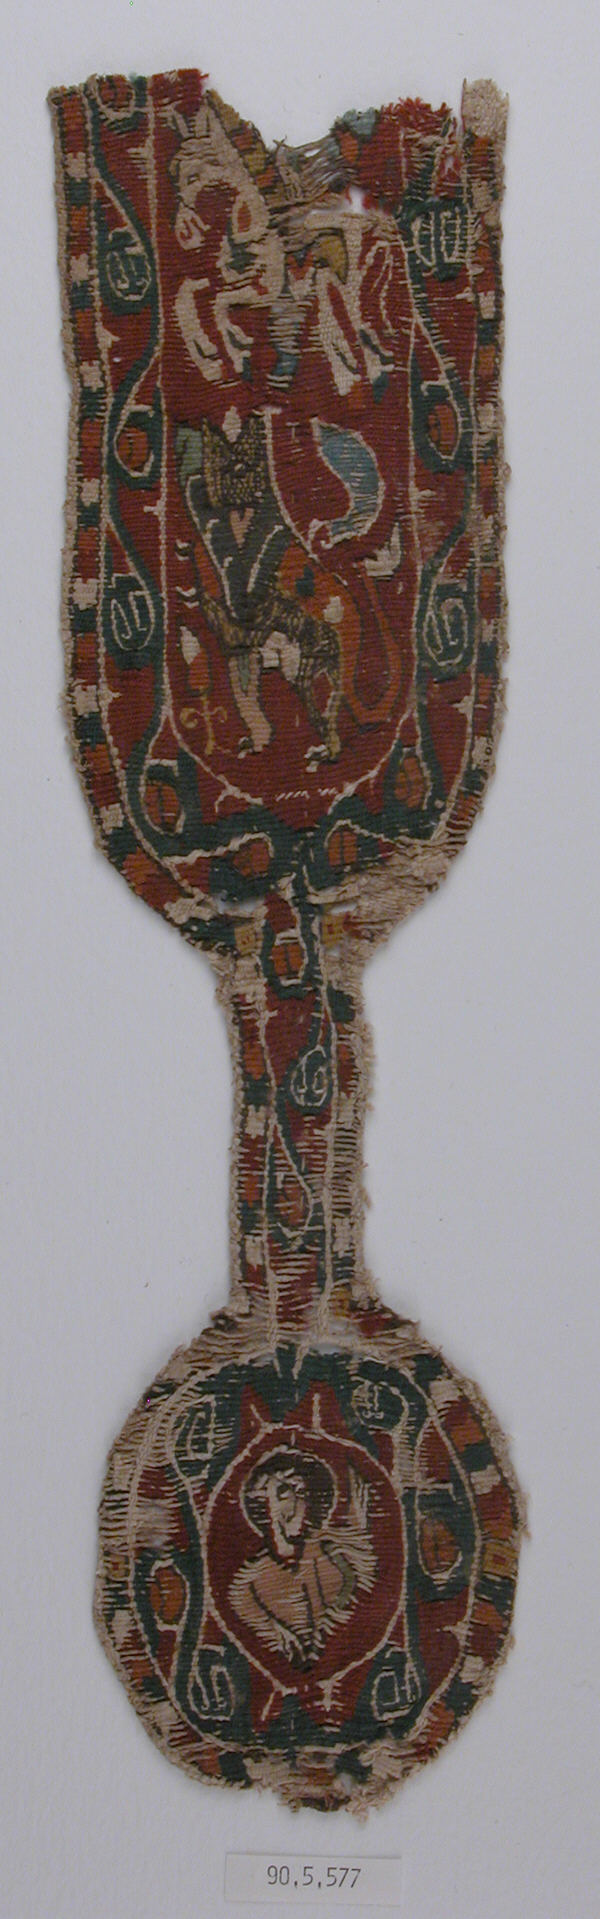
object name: textile fragment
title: Fragment of Shoulder Band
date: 501-700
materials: linen, wool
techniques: weave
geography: egypt